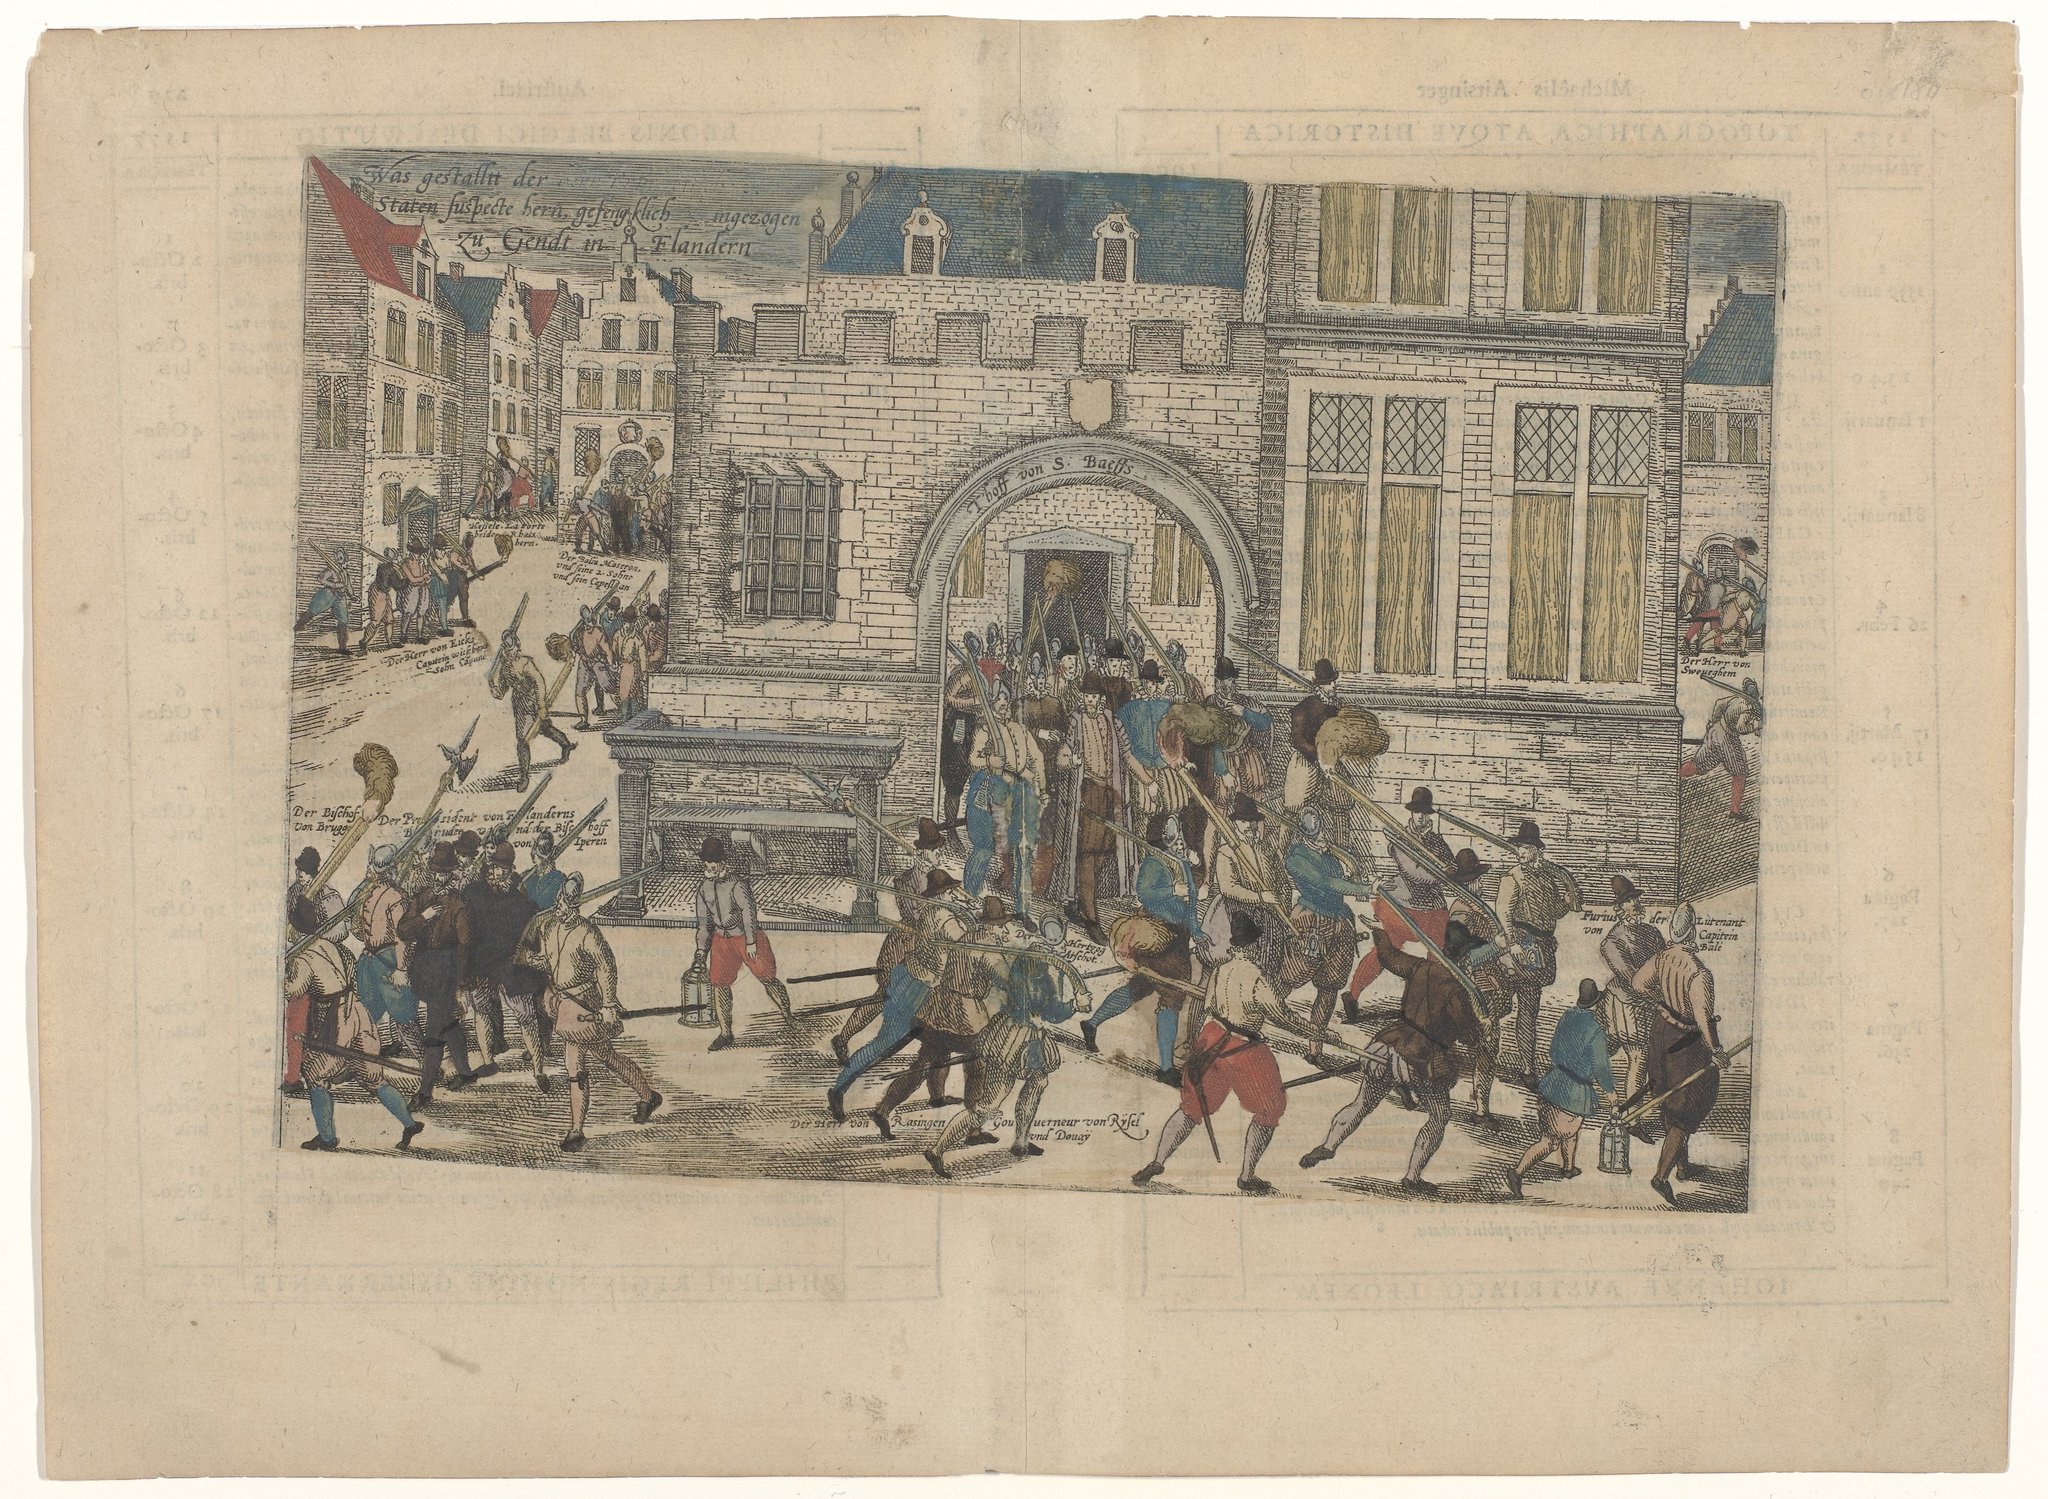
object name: print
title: Serie 8: Nederlandse Gebeurtenissen, 1577-1583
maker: frans hogenberg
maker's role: print maker, publisher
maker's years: 1538-1590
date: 1588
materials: paper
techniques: etching, hand coloring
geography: cologne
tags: venice, earl, imprisonment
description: De gevangenneming van de hertog van Aarschot en andere edelen in het Hof van S. Baeffs te Gent na een staatsgreep door calvinisten, 28 oktober 1577. Gedrukt met een cache over het onderschrift.